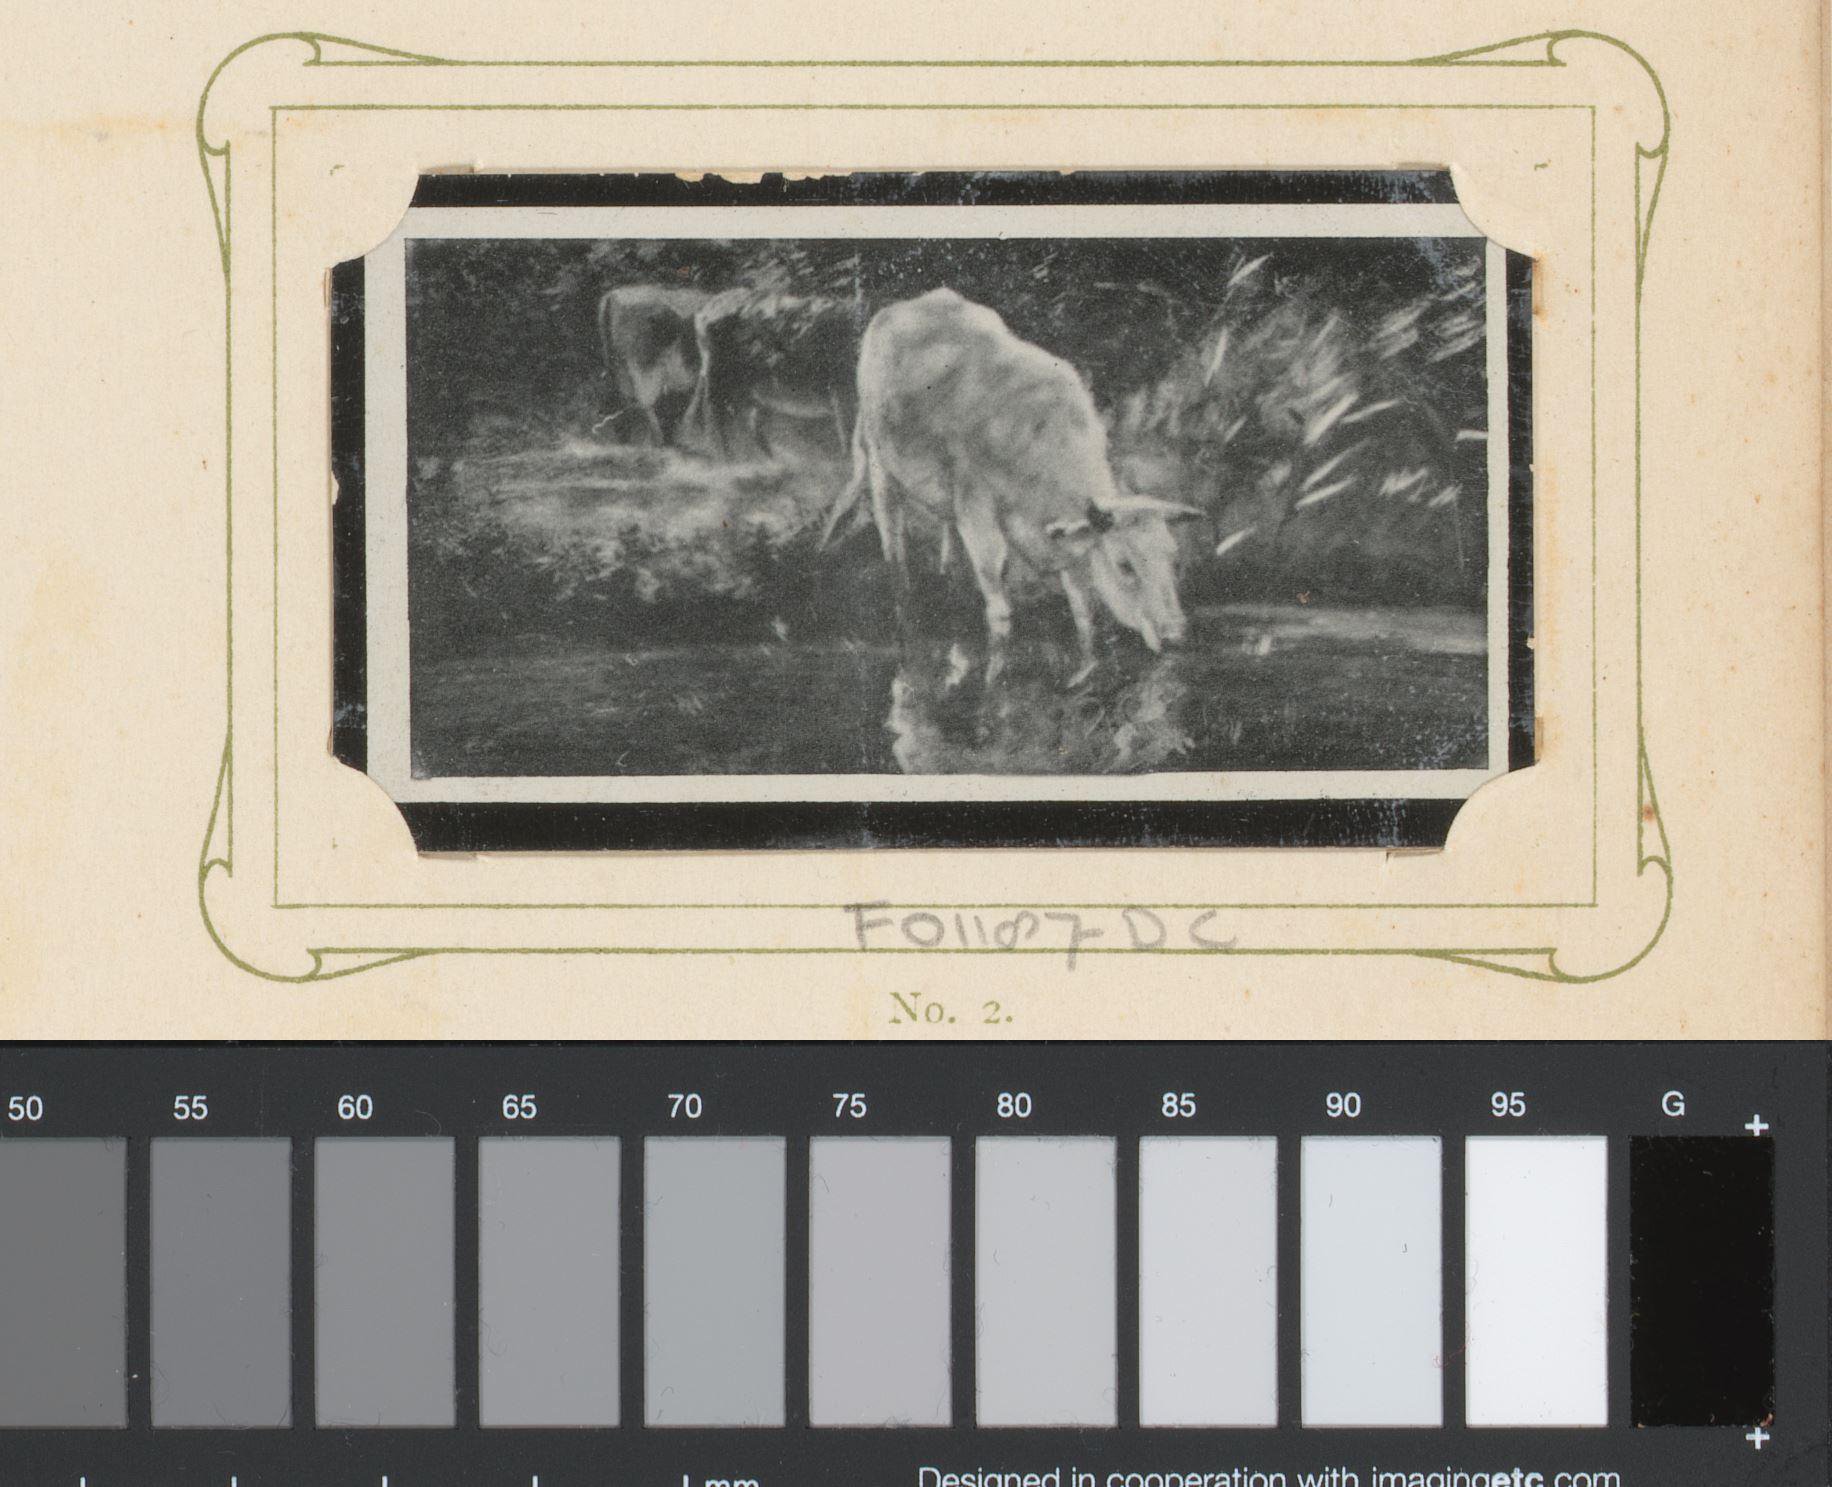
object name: album leaf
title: Reproductie van Drinkende koe door Willem Maris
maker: Anonymous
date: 1905-1906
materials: paper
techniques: photograph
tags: cow, drinking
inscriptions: inscription: ‘No. 2./ Drinkende koe, W. Maris.’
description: Deze prent maakt deel uit van een album.